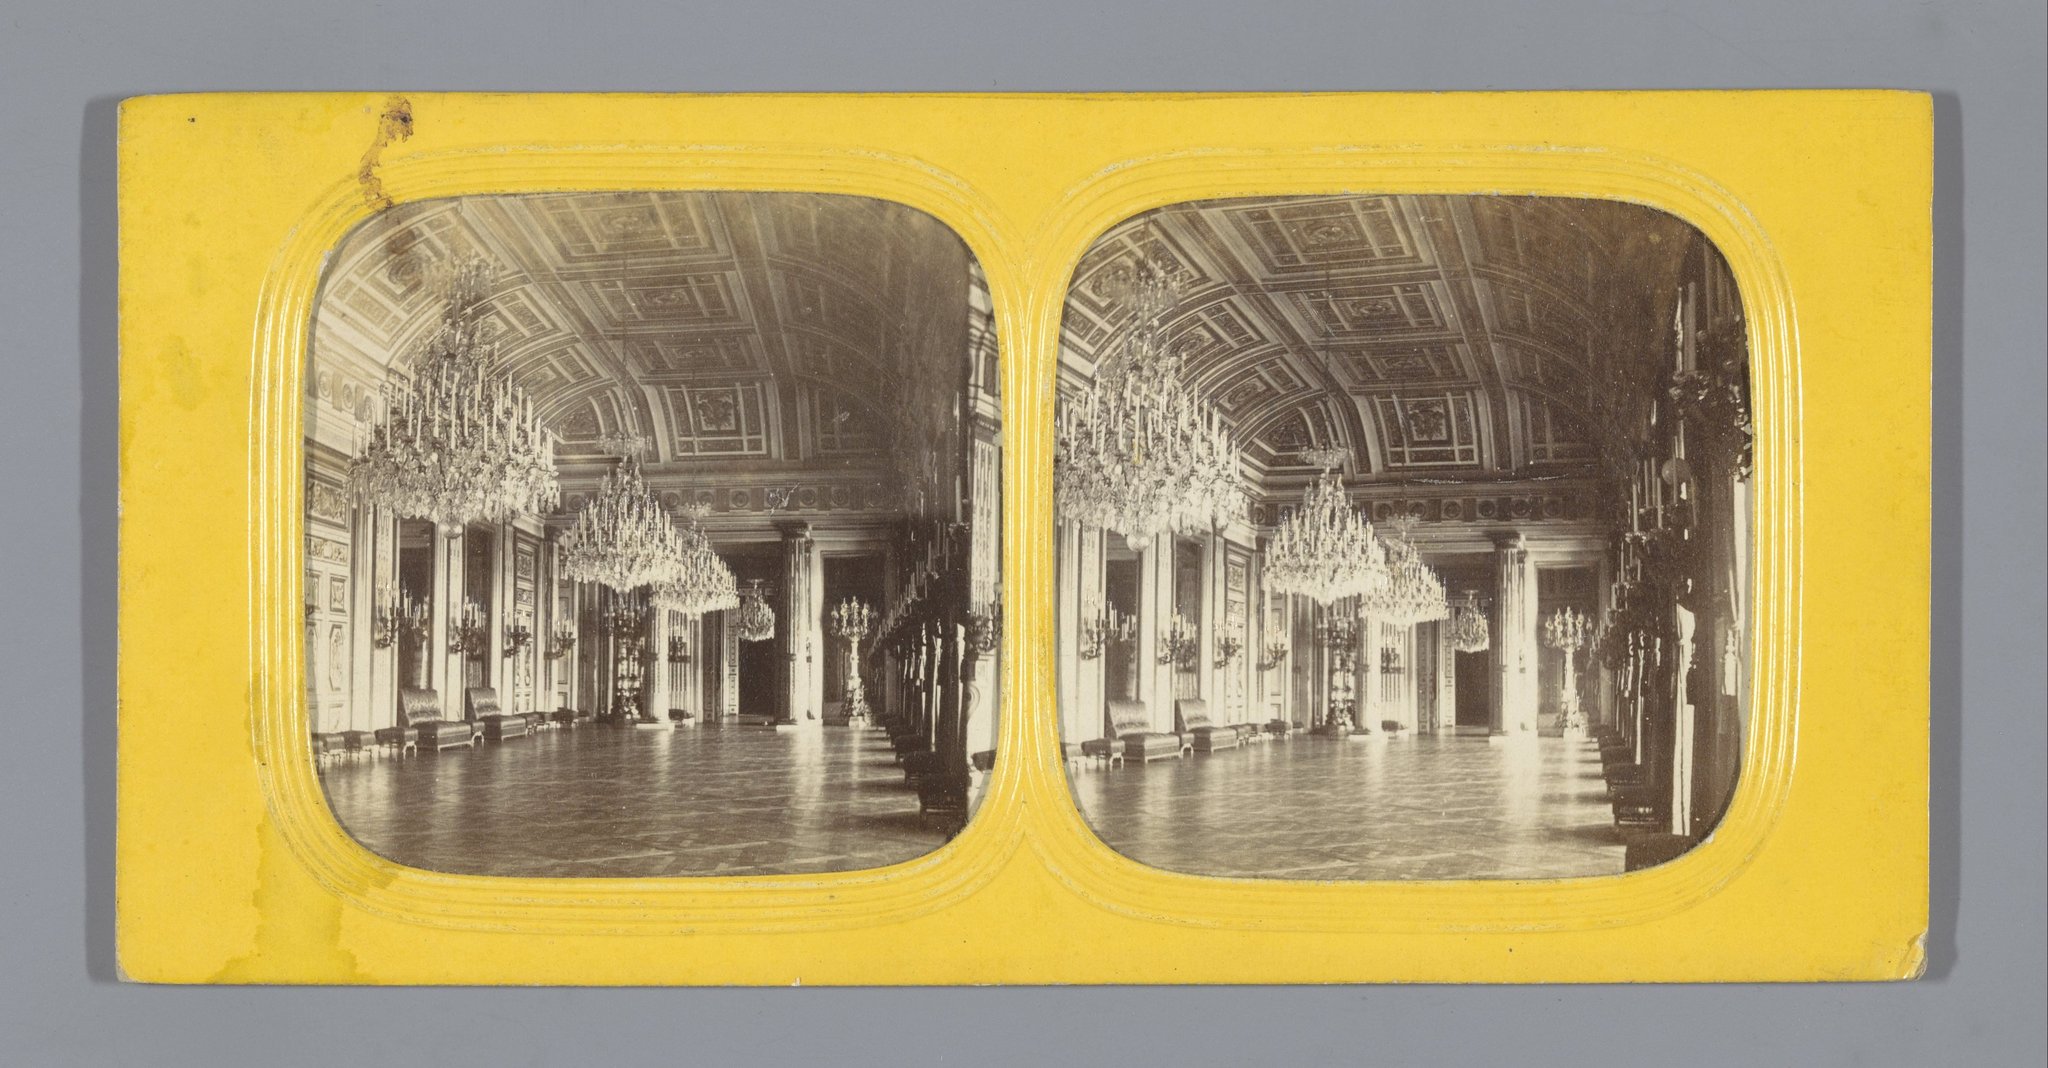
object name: tissue stereograph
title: Résidences impériales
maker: florent grau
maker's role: manufacturer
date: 1859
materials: cardboard, paper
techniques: albumen print, hand coloring, perforating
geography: paris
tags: palace - aa - civic architecture: inside, tuileries palace